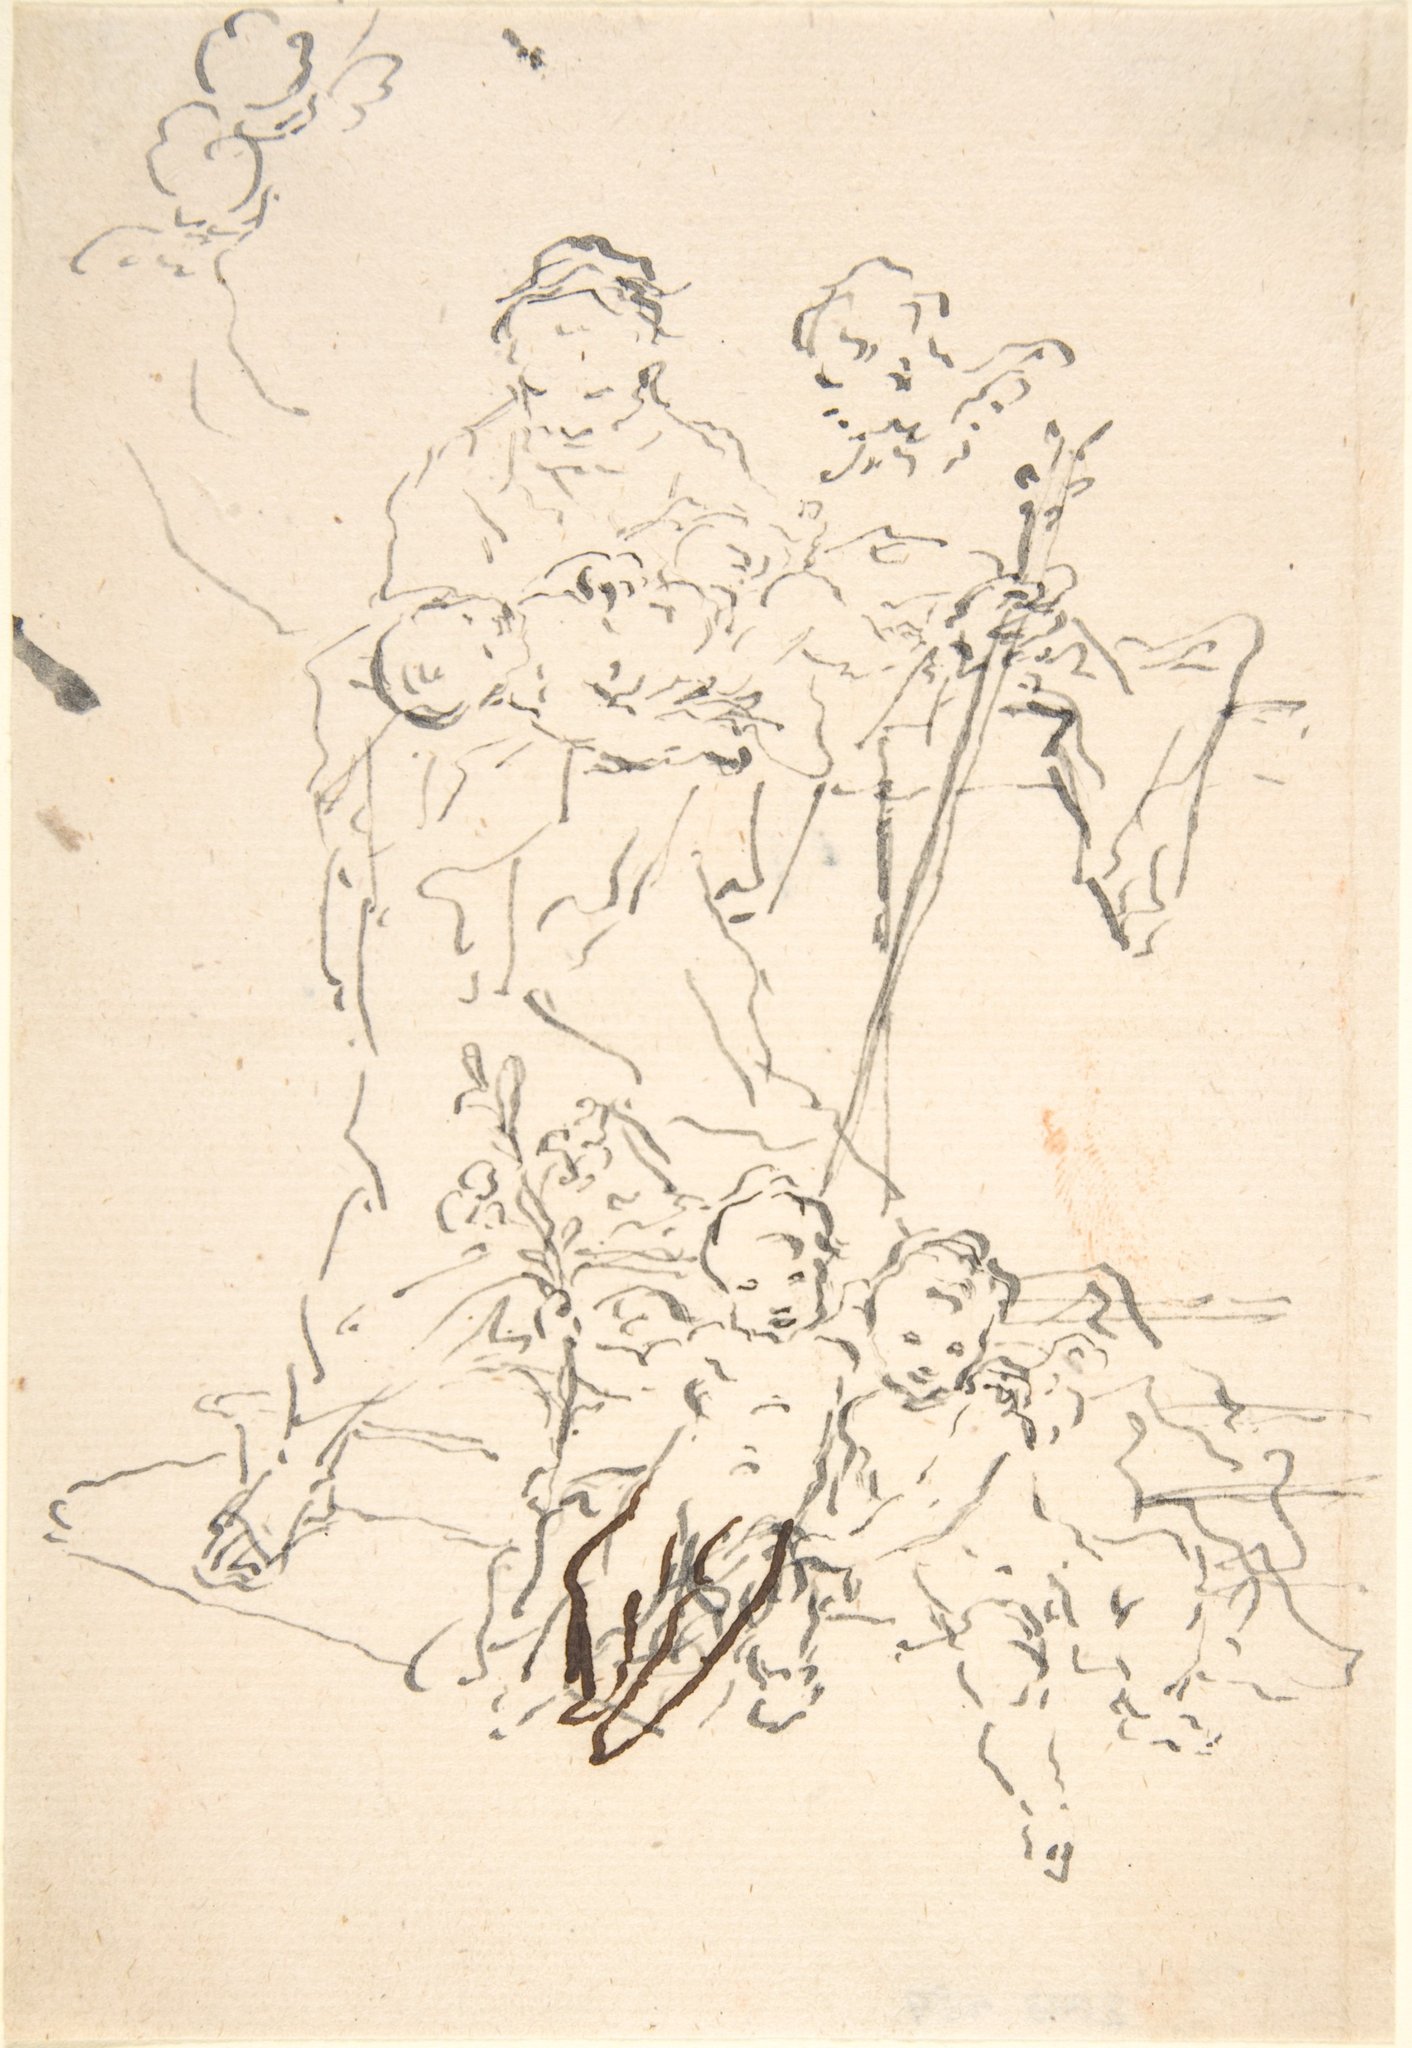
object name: drawing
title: Saint Anthony and the Christ Child Surrounded by Cherubs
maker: martin johann schmidt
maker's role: artist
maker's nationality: austrian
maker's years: 1718-1801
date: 1701-1800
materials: ink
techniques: pen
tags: angels,christ,saints